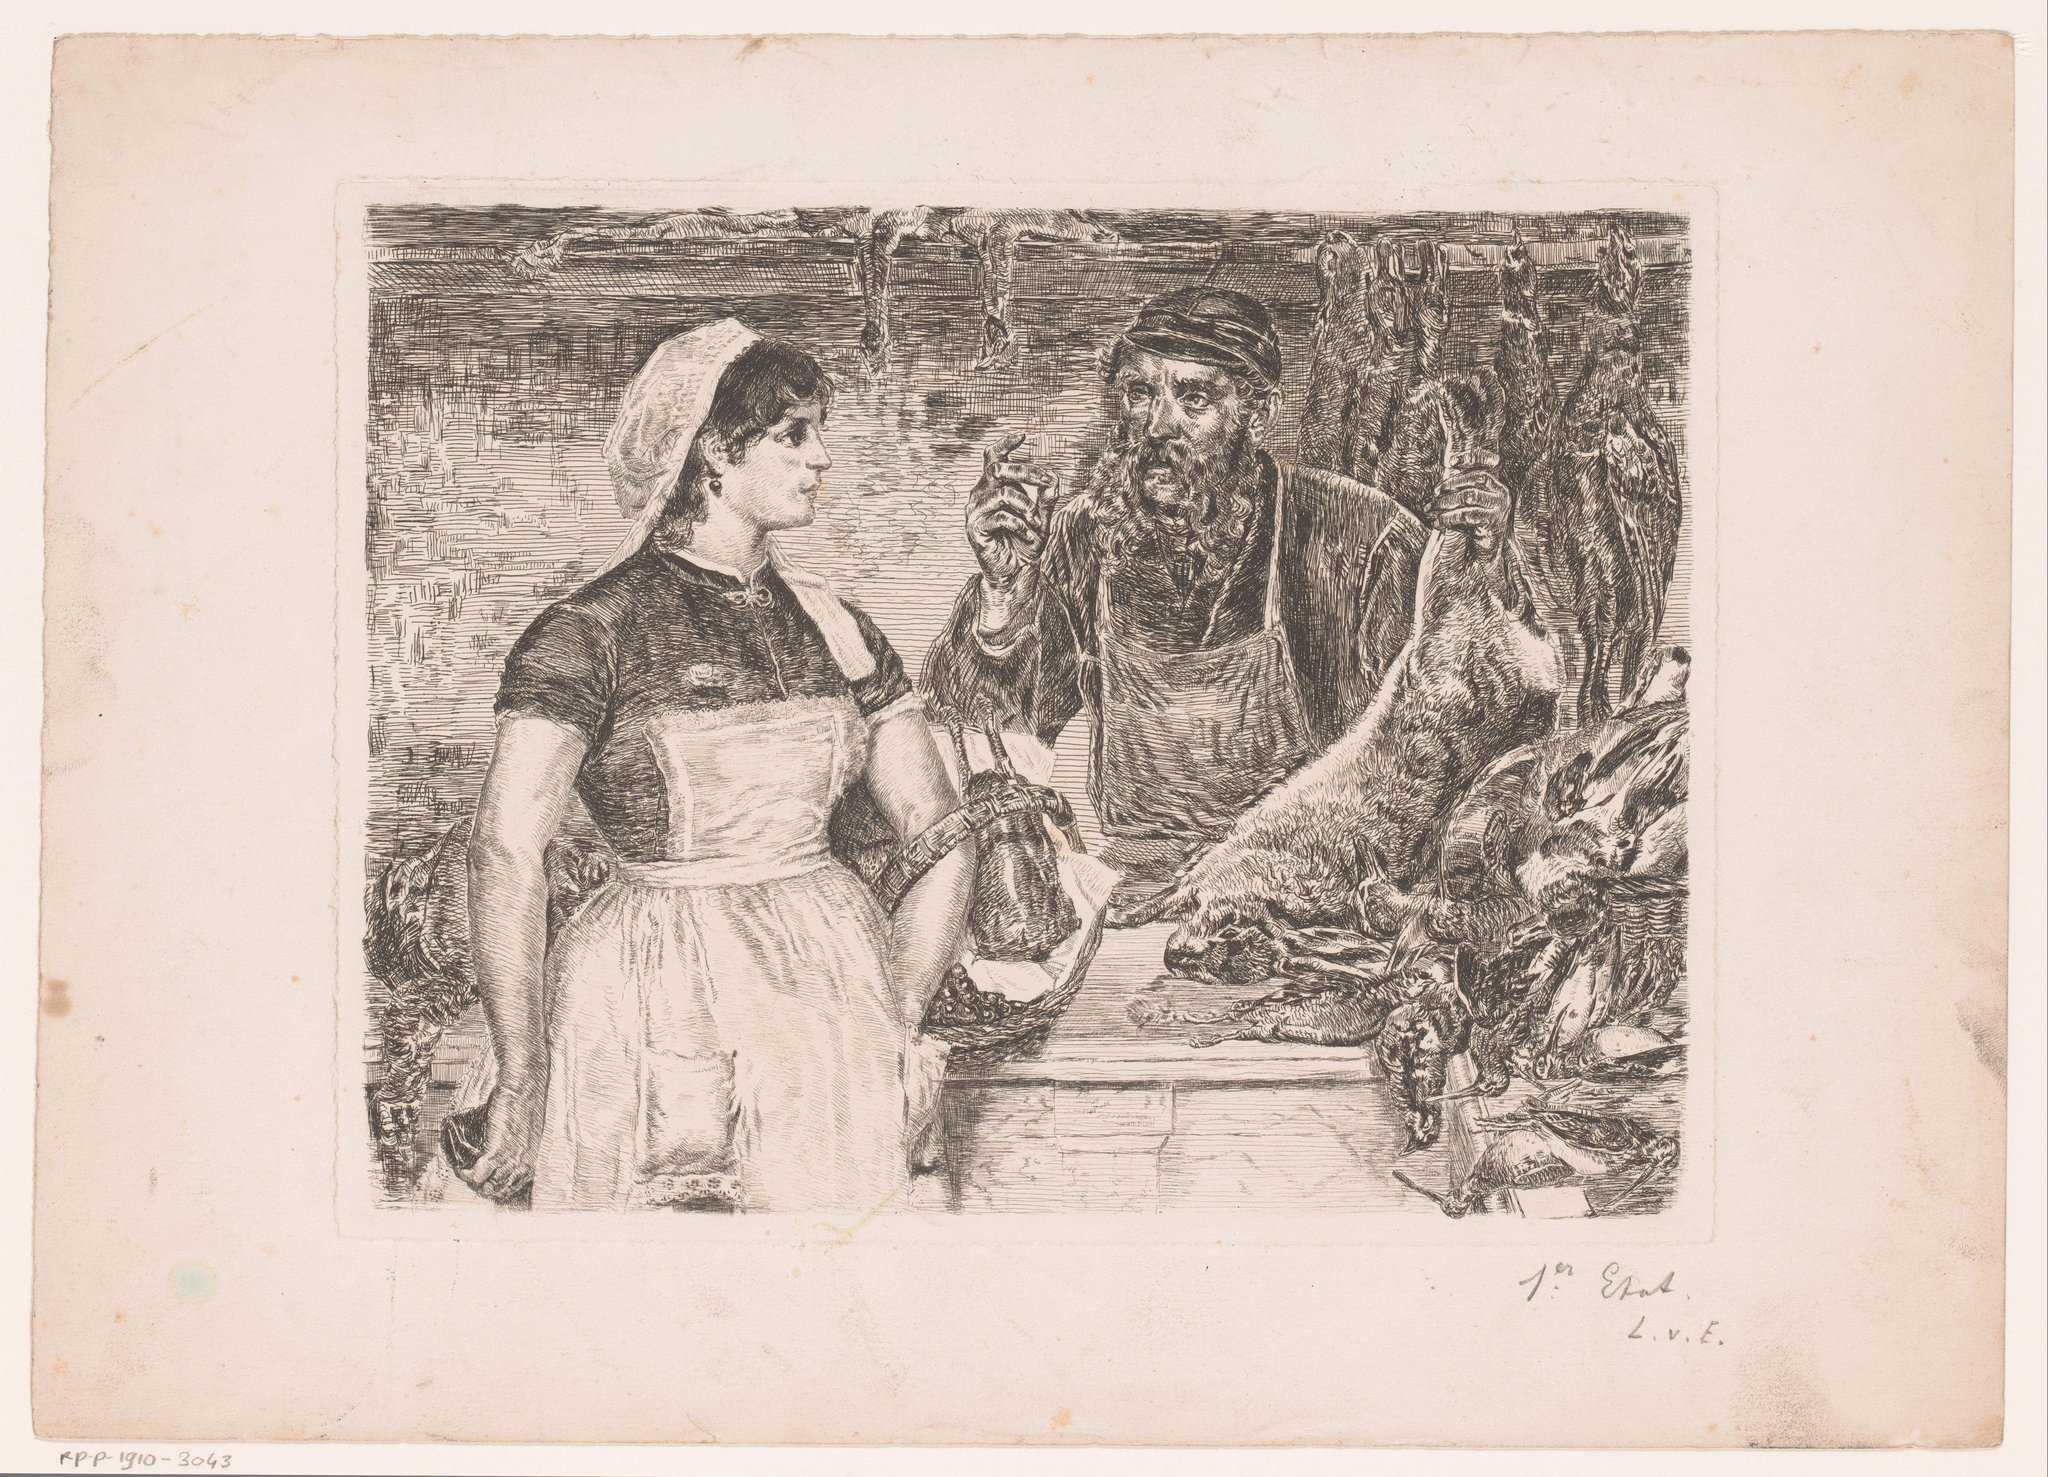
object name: print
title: Vrouw komt bij een vleesverkoper in zijn kraam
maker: louis van engelen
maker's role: print maker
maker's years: 1856-1940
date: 1866-1910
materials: paper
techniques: etching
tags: birds, rodents: hare, stall, booth (~ market), buying and selling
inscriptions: inscription: ‘1e Etat’, collector's mark: Lugt 2228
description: De verkoper houdt een haas in zijn handen en op de toonbank ligt gevogelte.